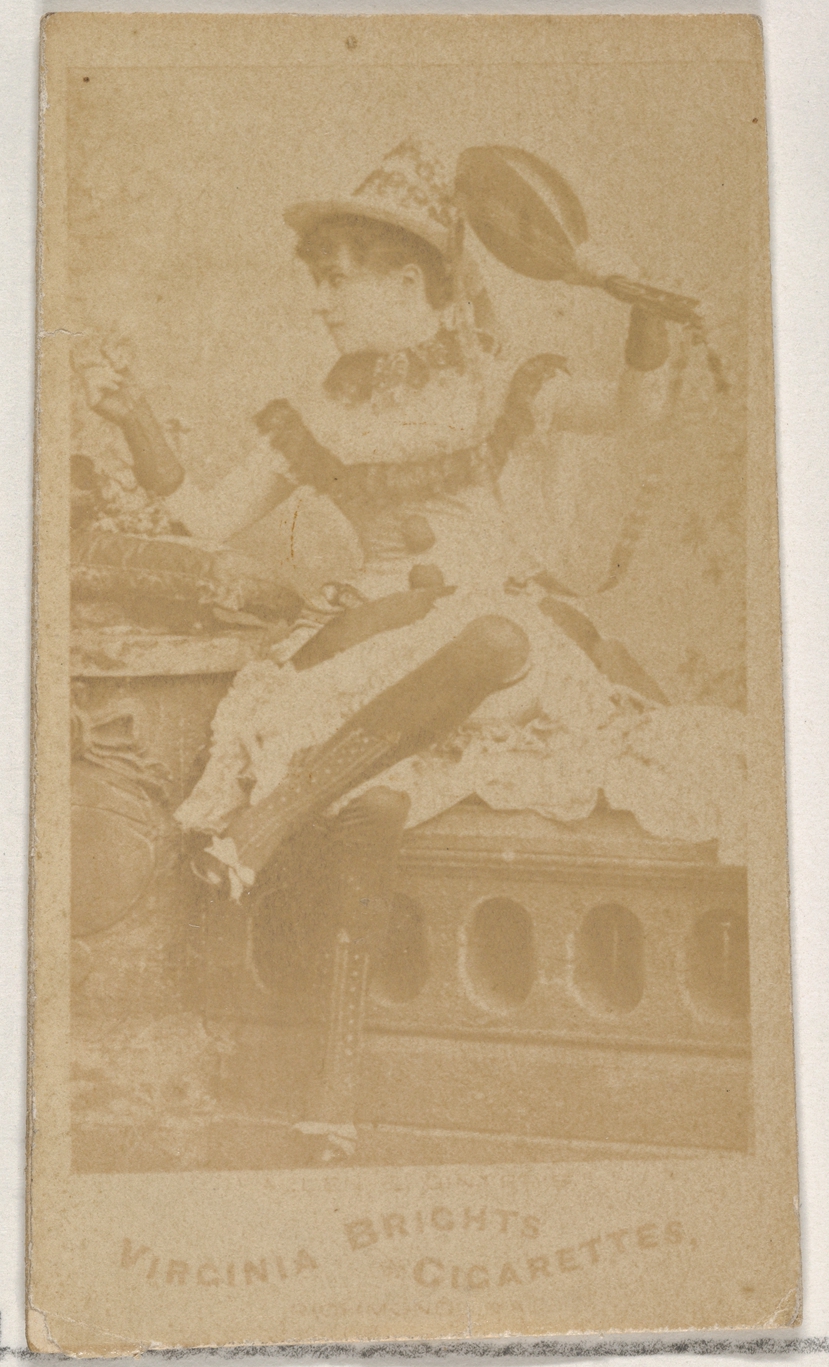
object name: photograph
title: From the Actors and Actresses series (N45, Type 5) for Virginia Brights Cigarettes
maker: allen & ginter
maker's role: publisher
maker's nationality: american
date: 1888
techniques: albumen silver print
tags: women,actresses